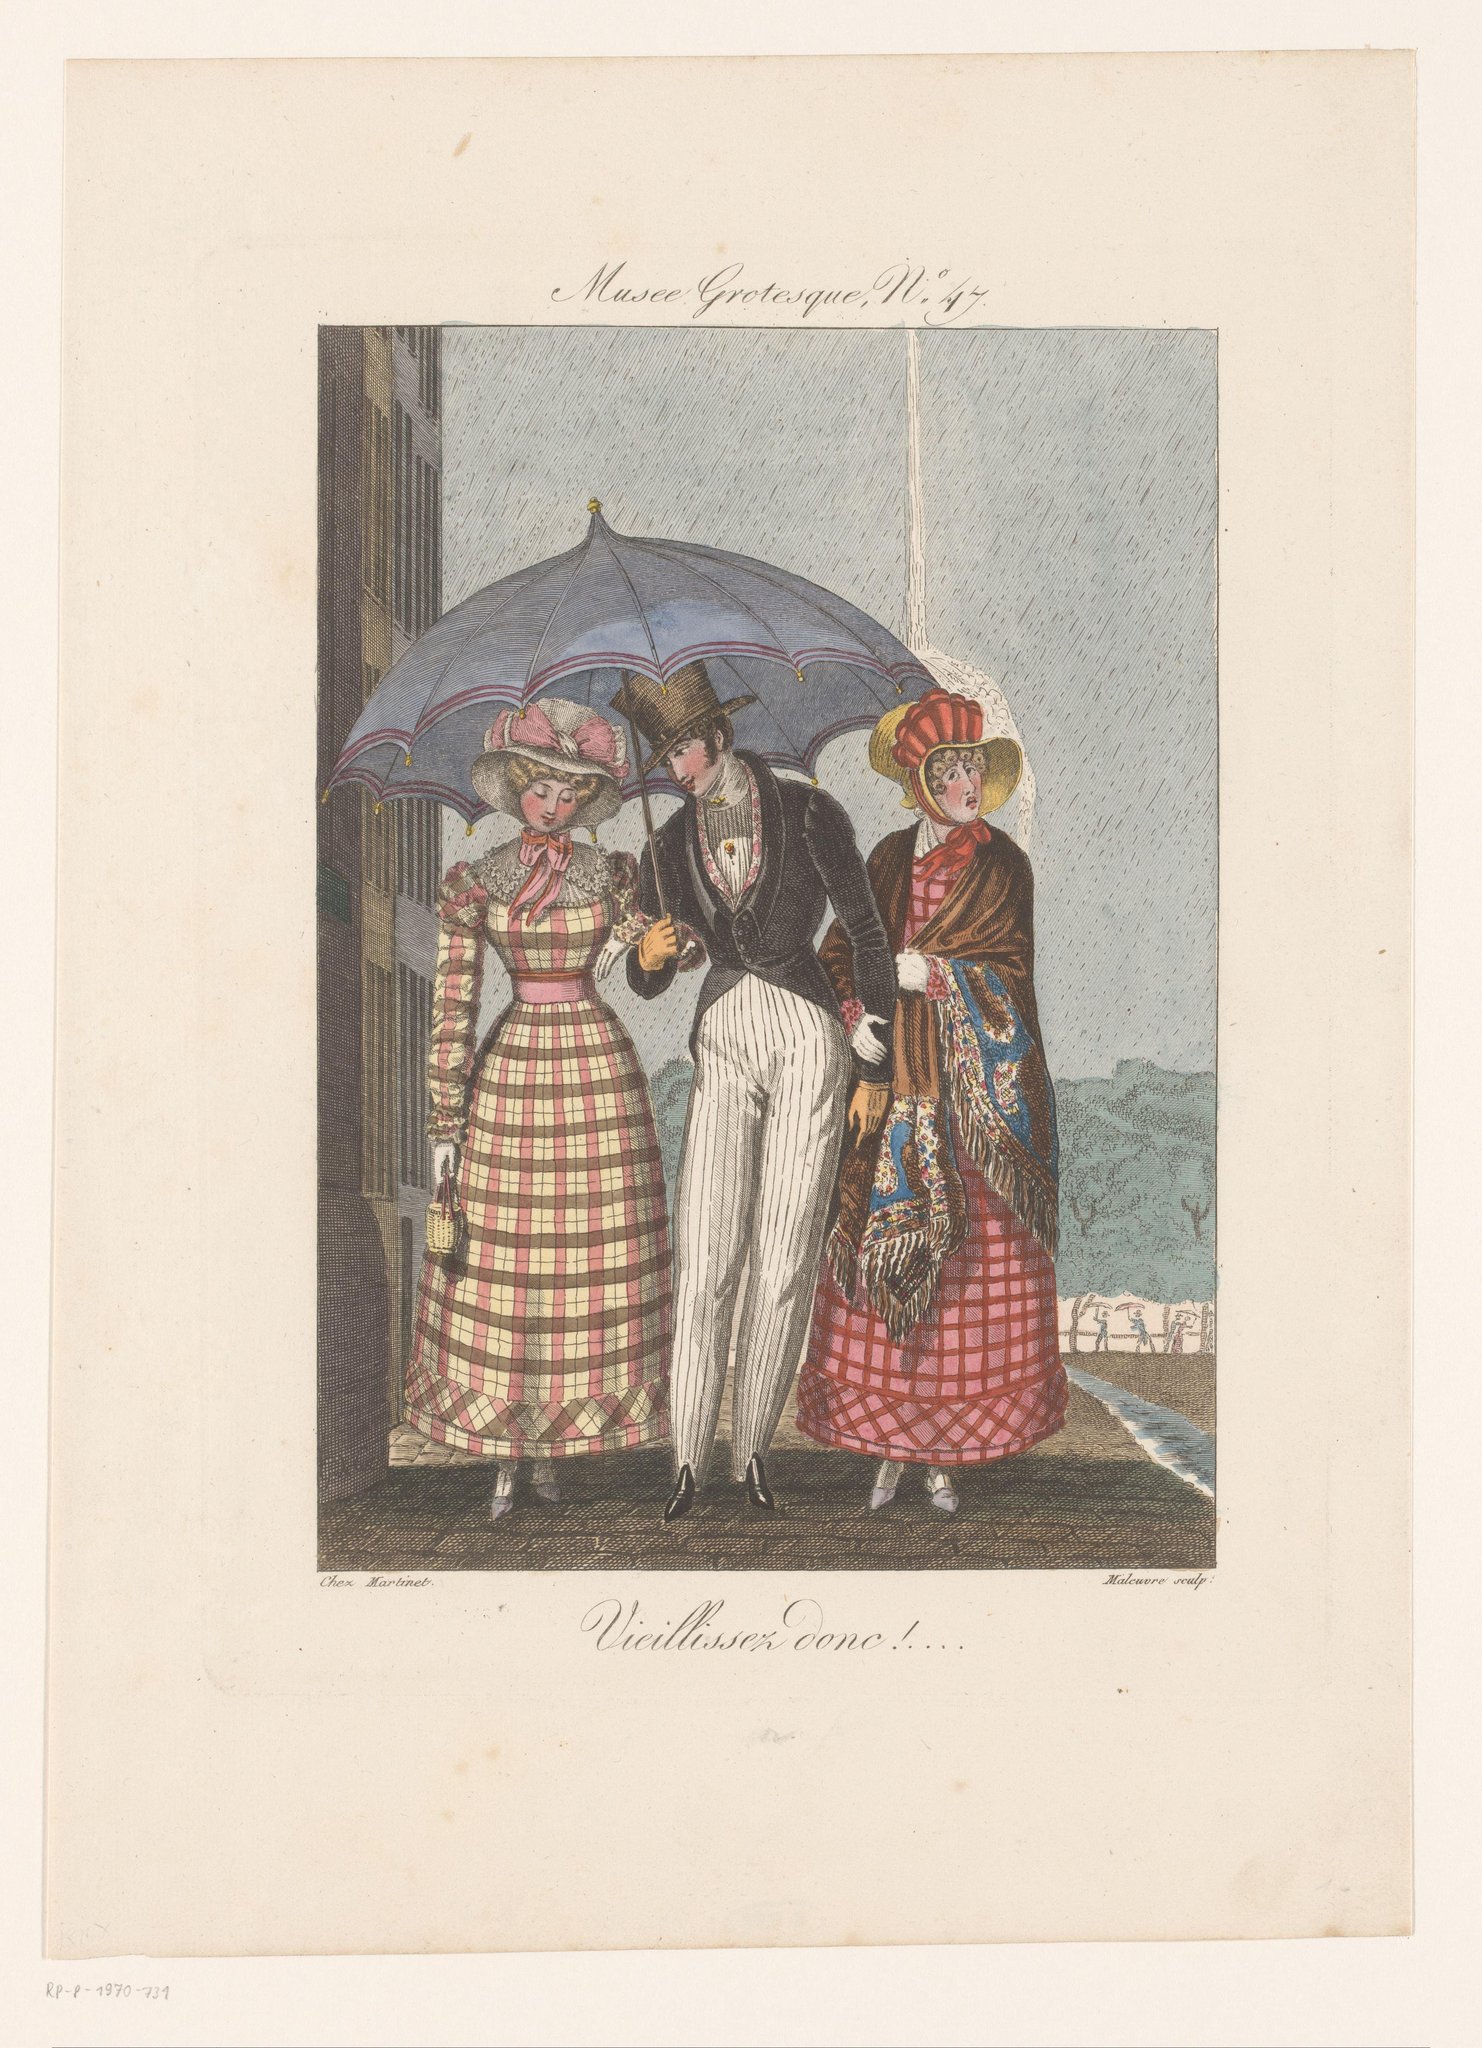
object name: print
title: Musée Grotesque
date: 1772-1803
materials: paper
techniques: etching, hand coloring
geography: paris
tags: rain, young versus old age; young and old, umbrella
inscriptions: collector's mark: Lugt 2228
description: Boven genummerd: 47. Humoristische prent waar de oudere vrouw nat wordt door de regen omdat ze niet meer onder de paraplu kan: een jongere vrouw heeft haar plaats ingenomen.